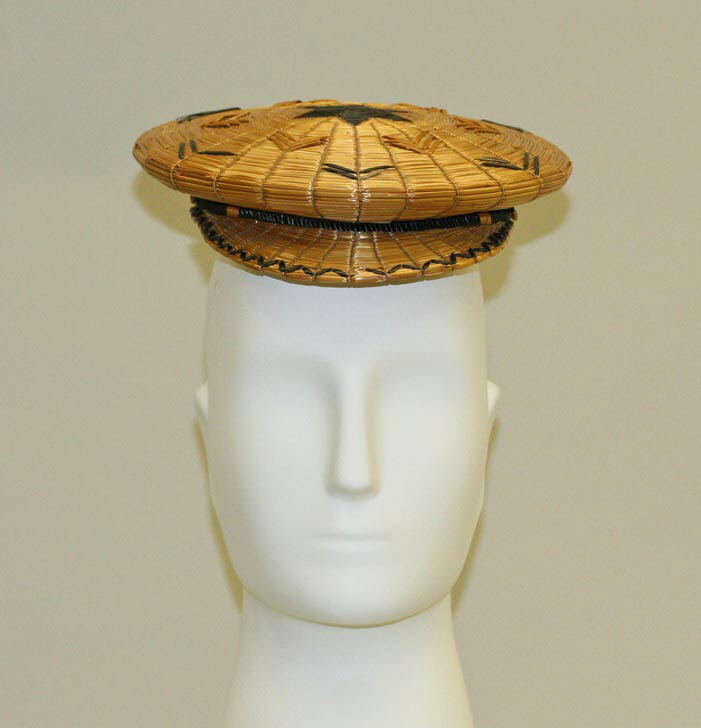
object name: hat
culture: american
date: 1896-1898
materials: fiber